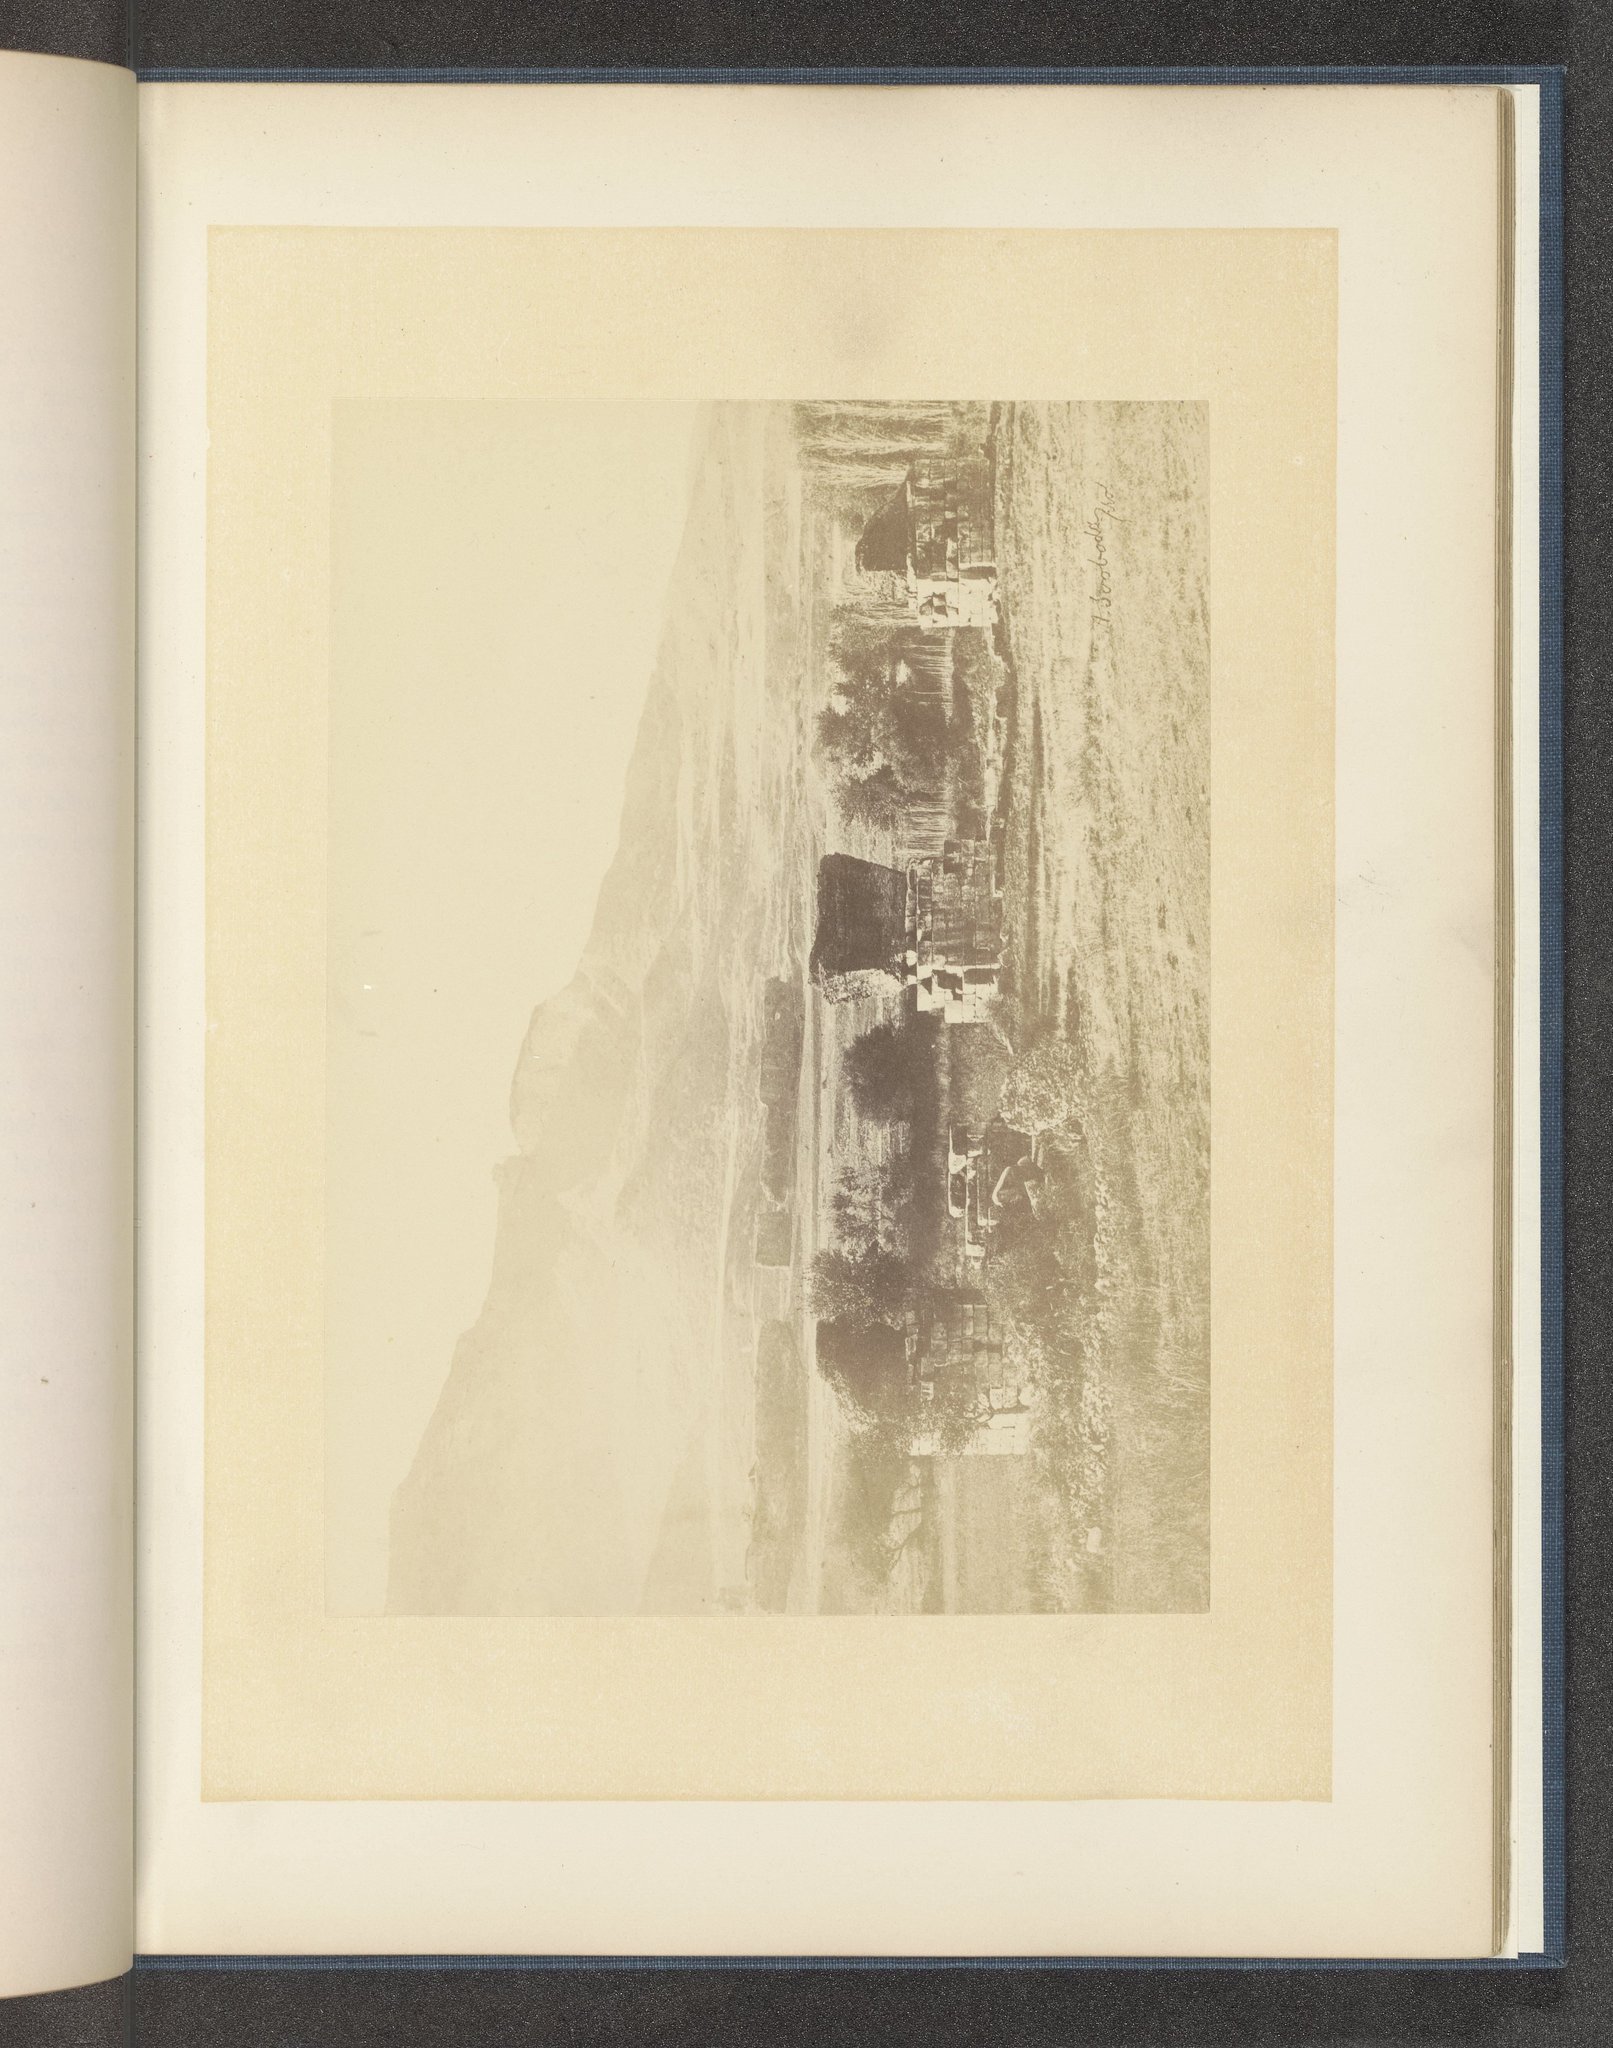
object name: photograph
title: Gezicht op de ruïne van een kerk te Sardis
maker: alexander svoboda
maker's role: fotograaf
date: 1859-1869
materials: photographic support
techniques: albumen print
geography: sardis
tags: ruin of church, monastery, etc.